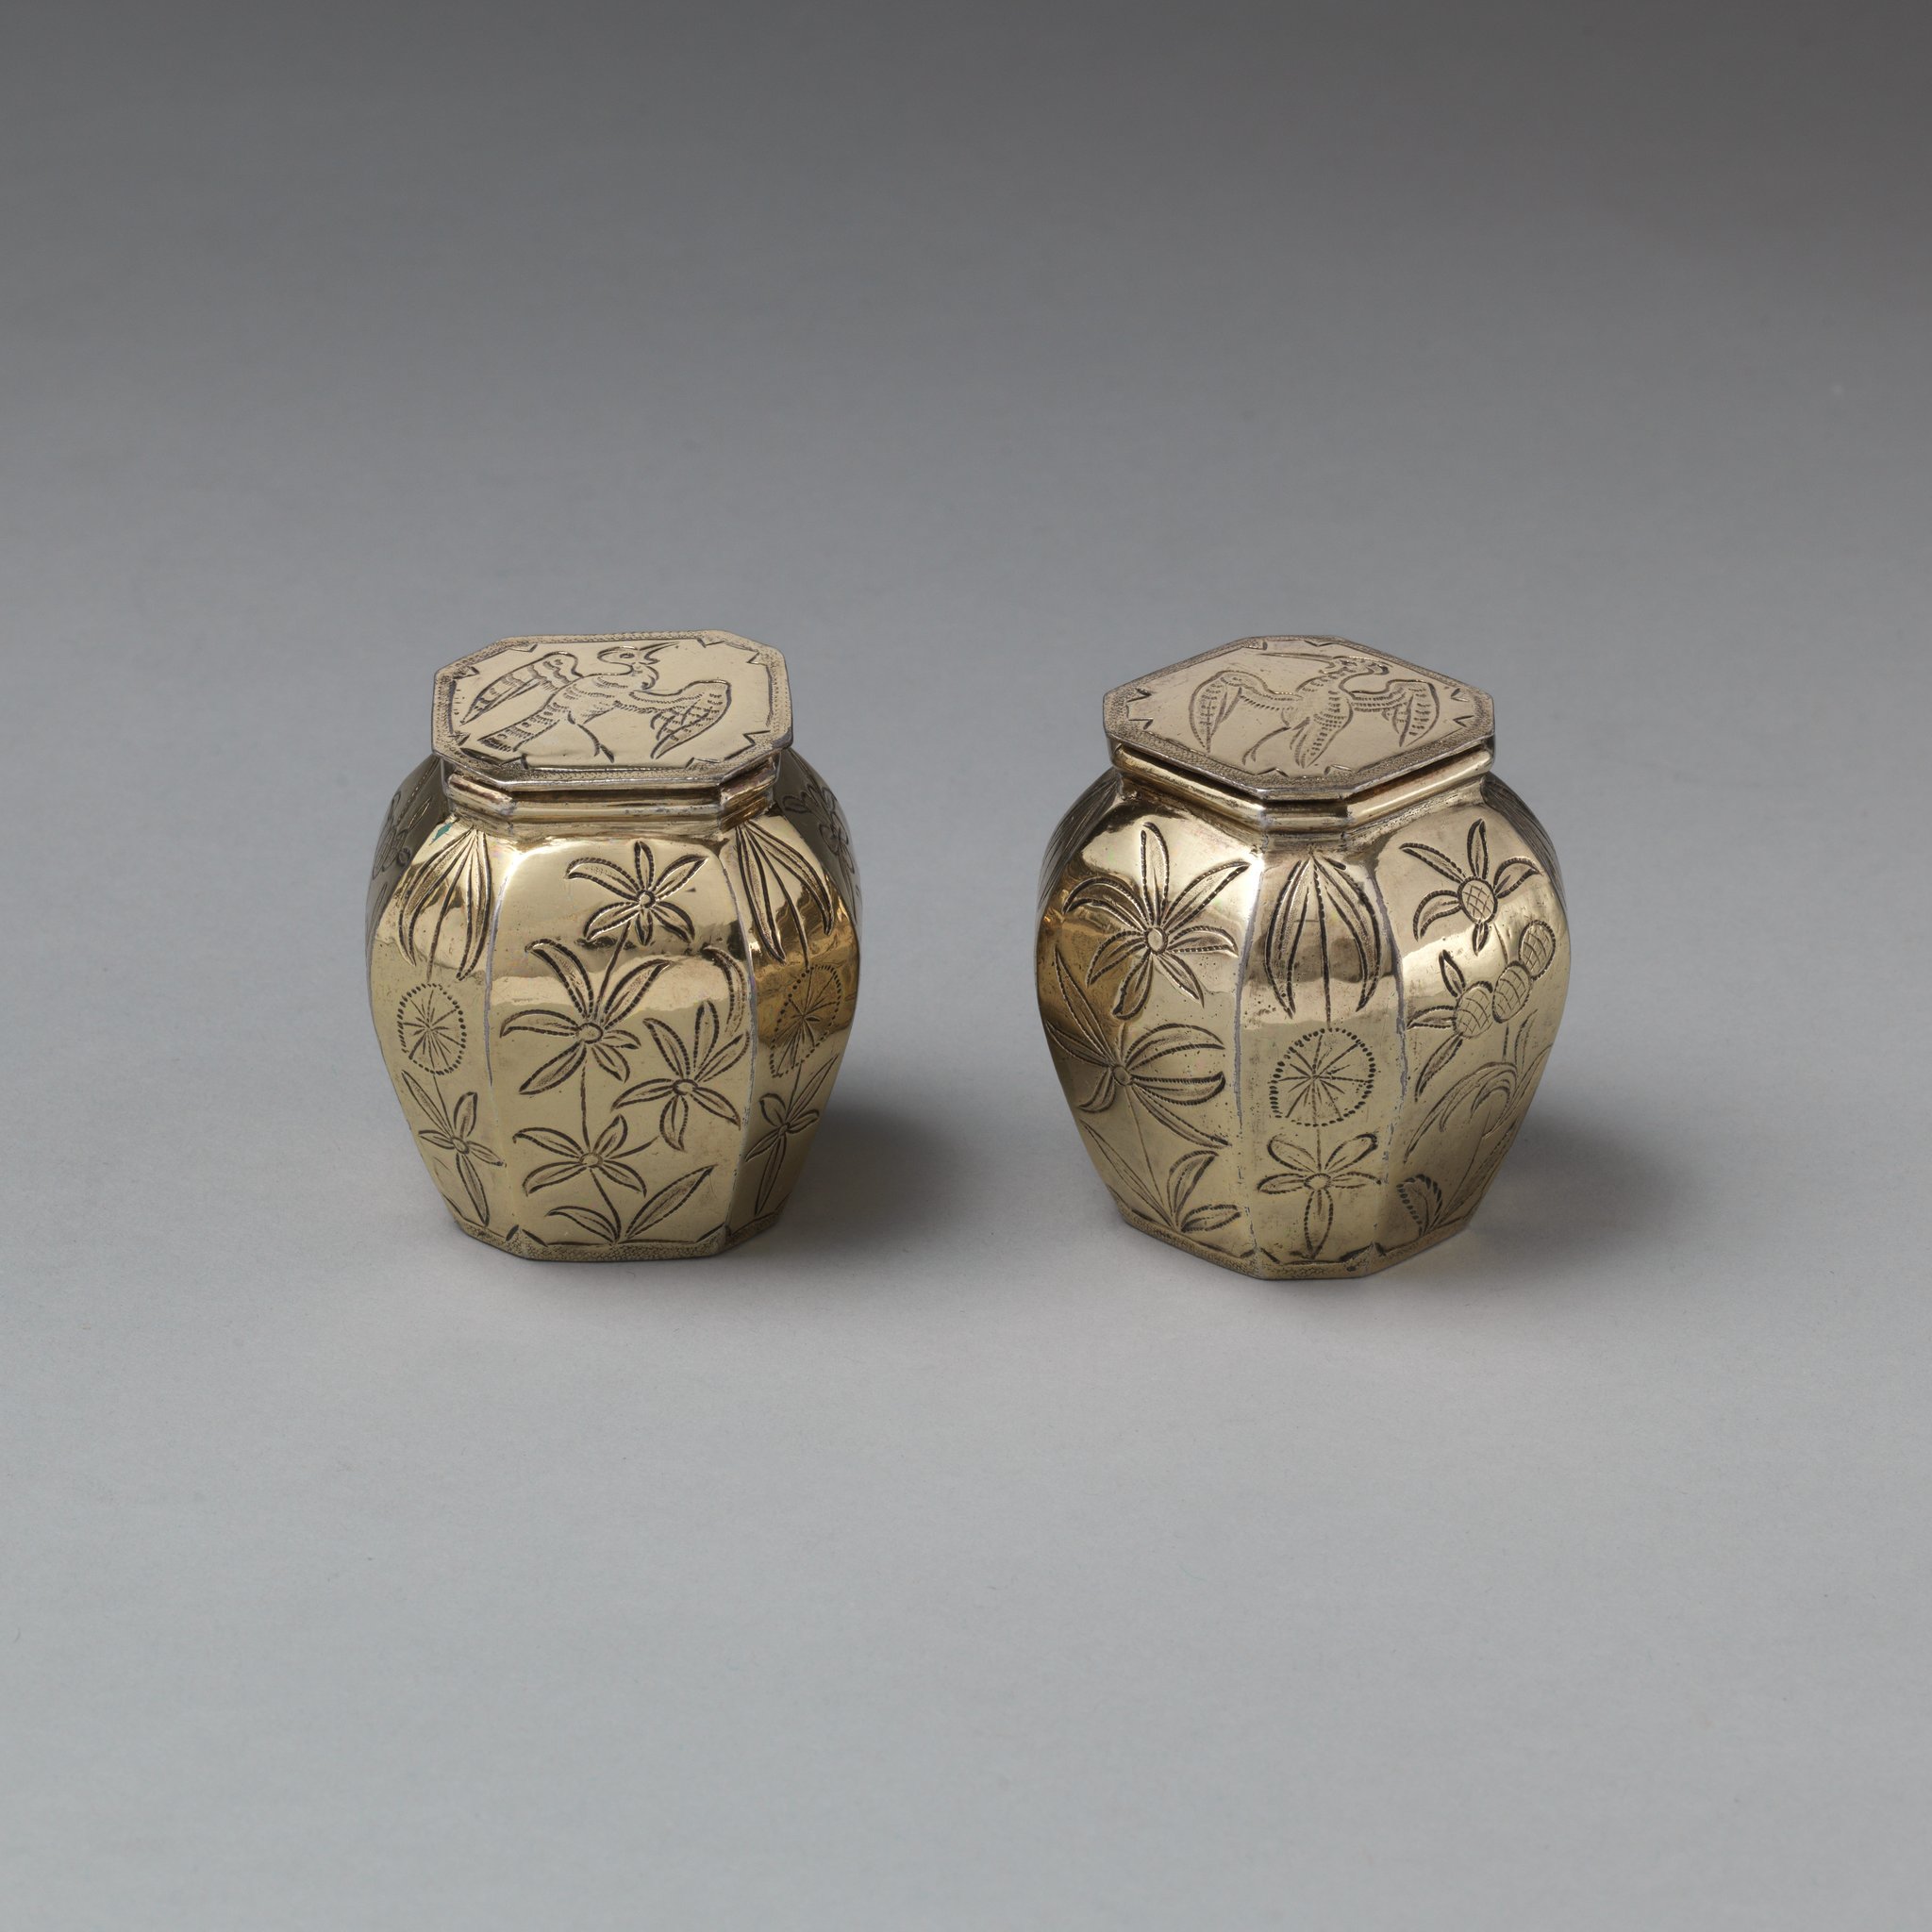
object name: pomade pot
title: Pair of pomade pots (part of a toilet service)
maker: thomas jenkins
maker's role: maker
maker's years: 1668-1708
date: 1684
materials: silver gilt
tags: birds,flowers